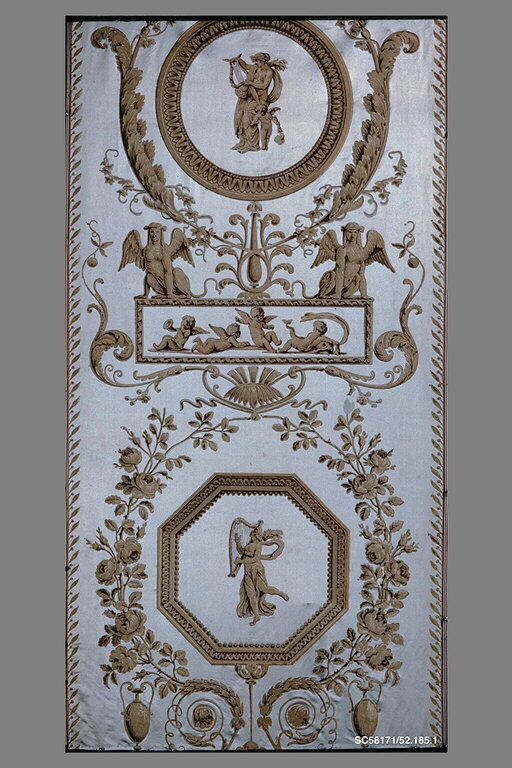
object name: panel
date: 1880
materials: textile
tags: women,harps